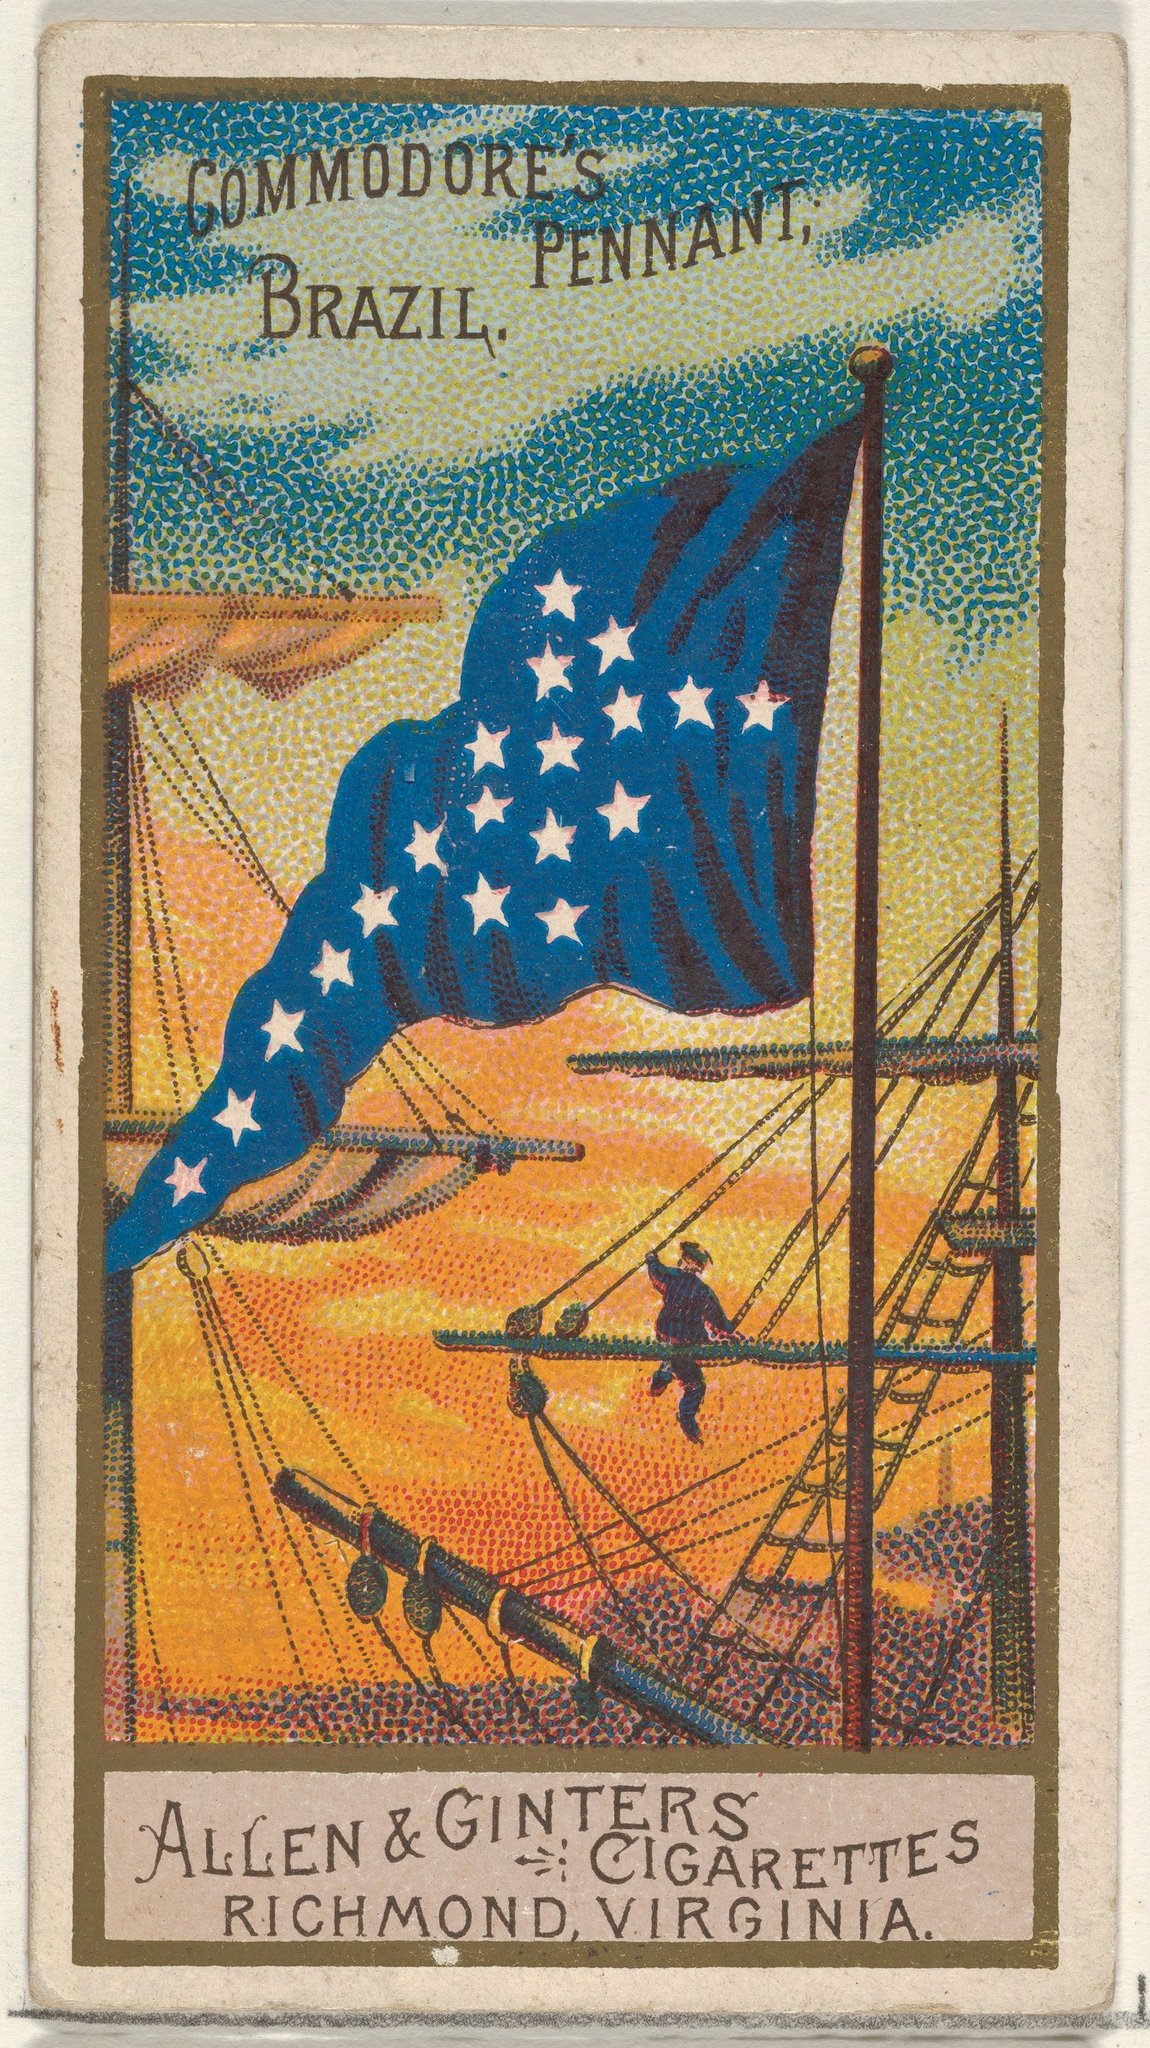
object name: print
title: Commodore's Pennant, Brazil, from the Naval Flags series (N17) for Allen & Ginter Cigarettes Brands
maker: allen & ginter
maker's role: publisher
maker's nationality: american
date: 1888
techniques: color lithograph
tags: flags